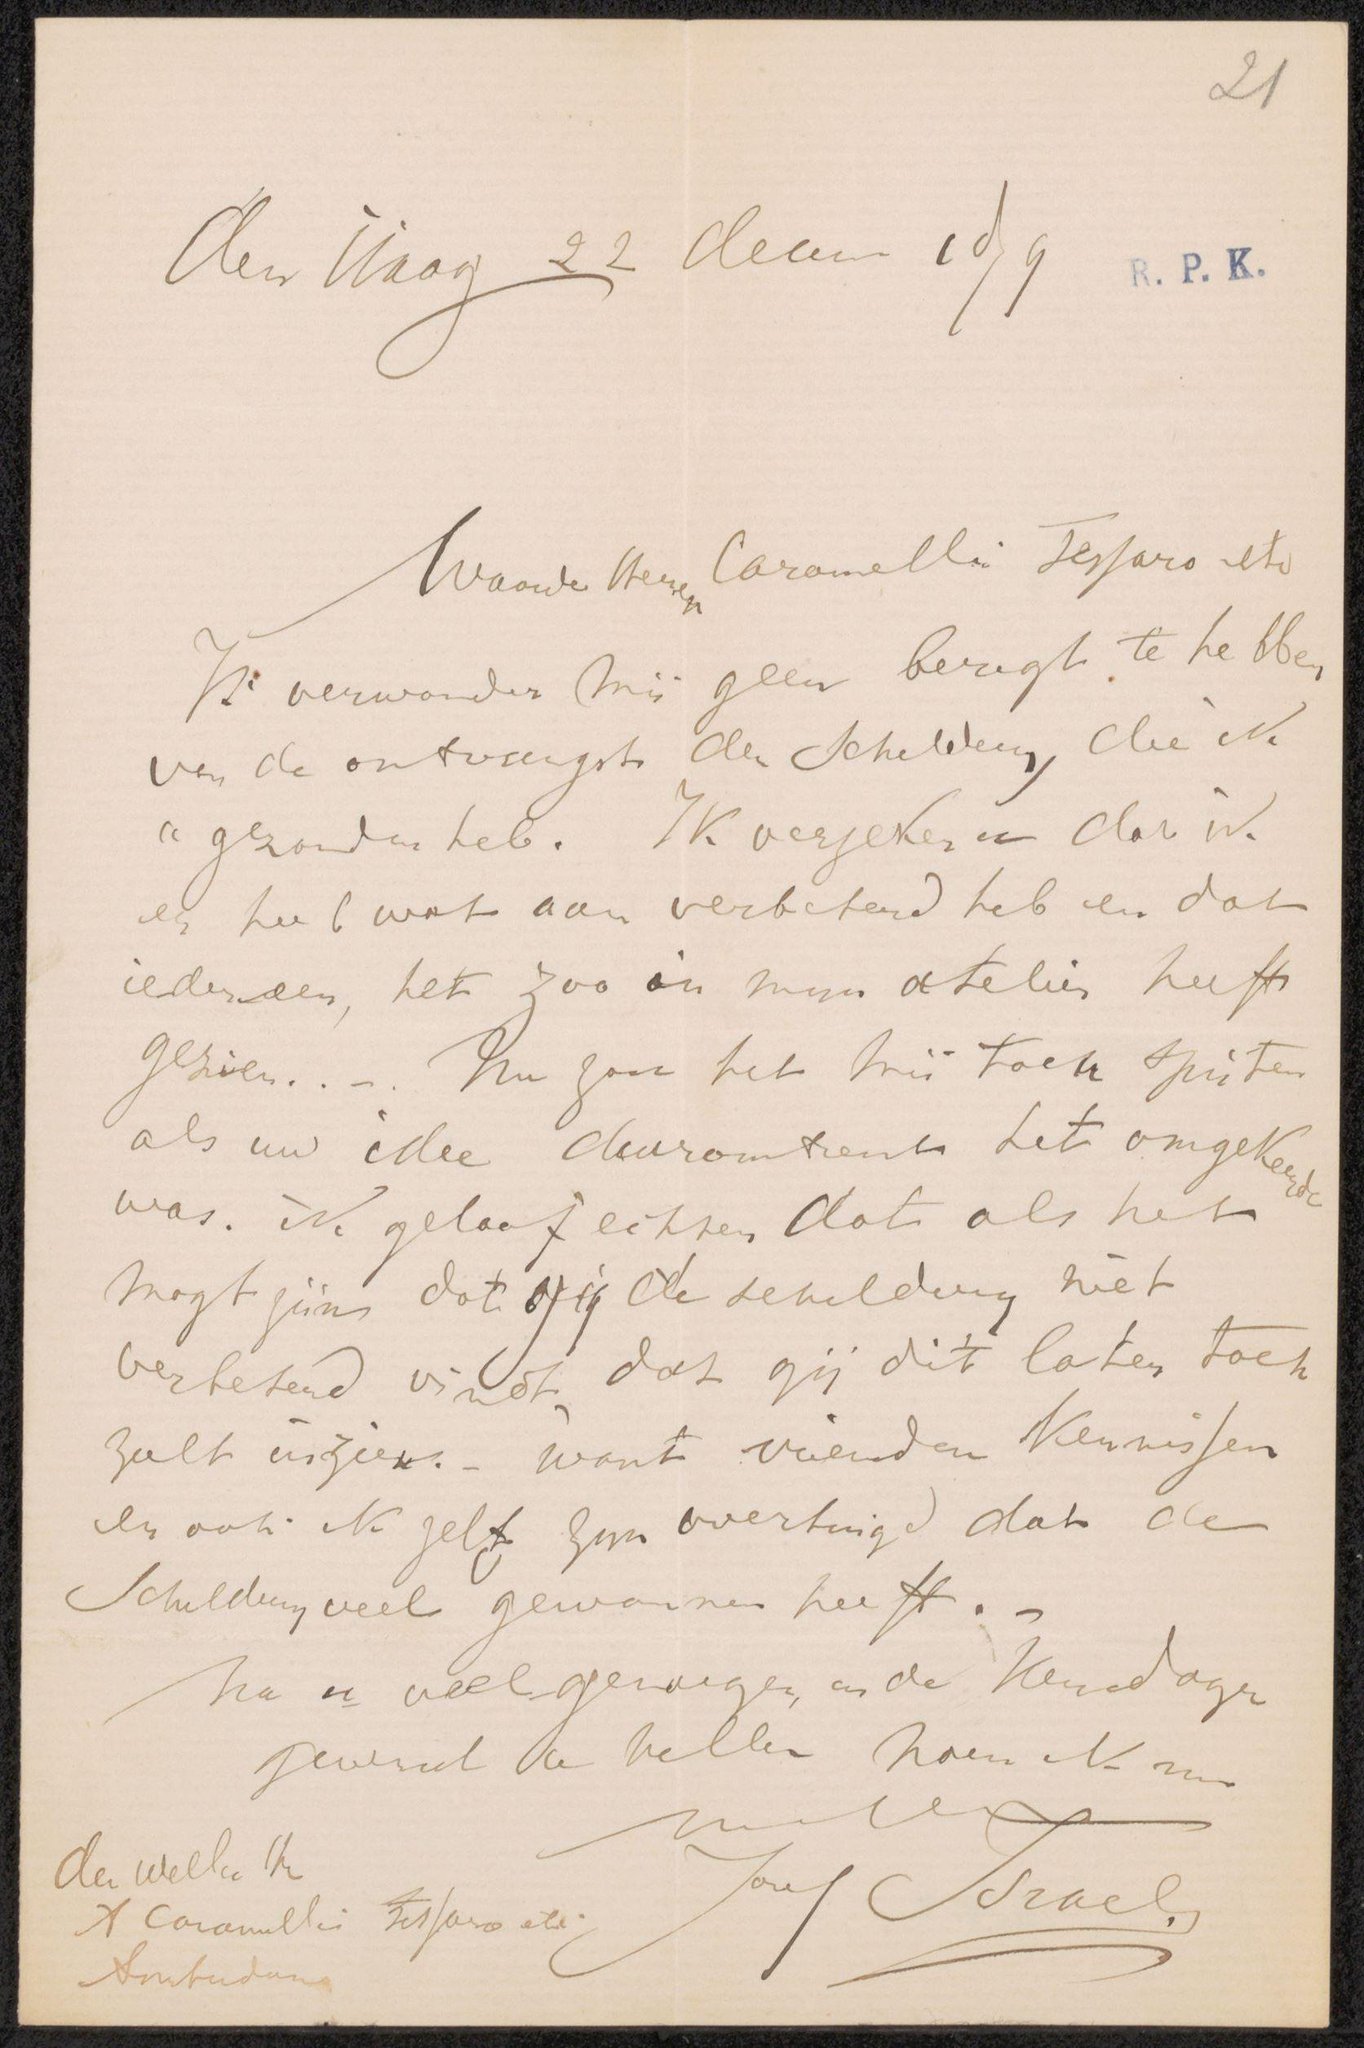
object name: letter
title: Brief aan Alberto Caramelli en Filippo Tessaro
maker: jozef israëls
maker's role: draughtsman, painter, print maker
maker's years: 1824-1911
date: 1879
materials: ink, paper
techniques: pen, writing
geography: the hague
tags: utrecht, amsterdam, publisher, alberto caramelli, painting (including book-illumination, miniature-painting), workshop, studio of the artist (in general)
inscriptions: collector's mark: Lugt 2233